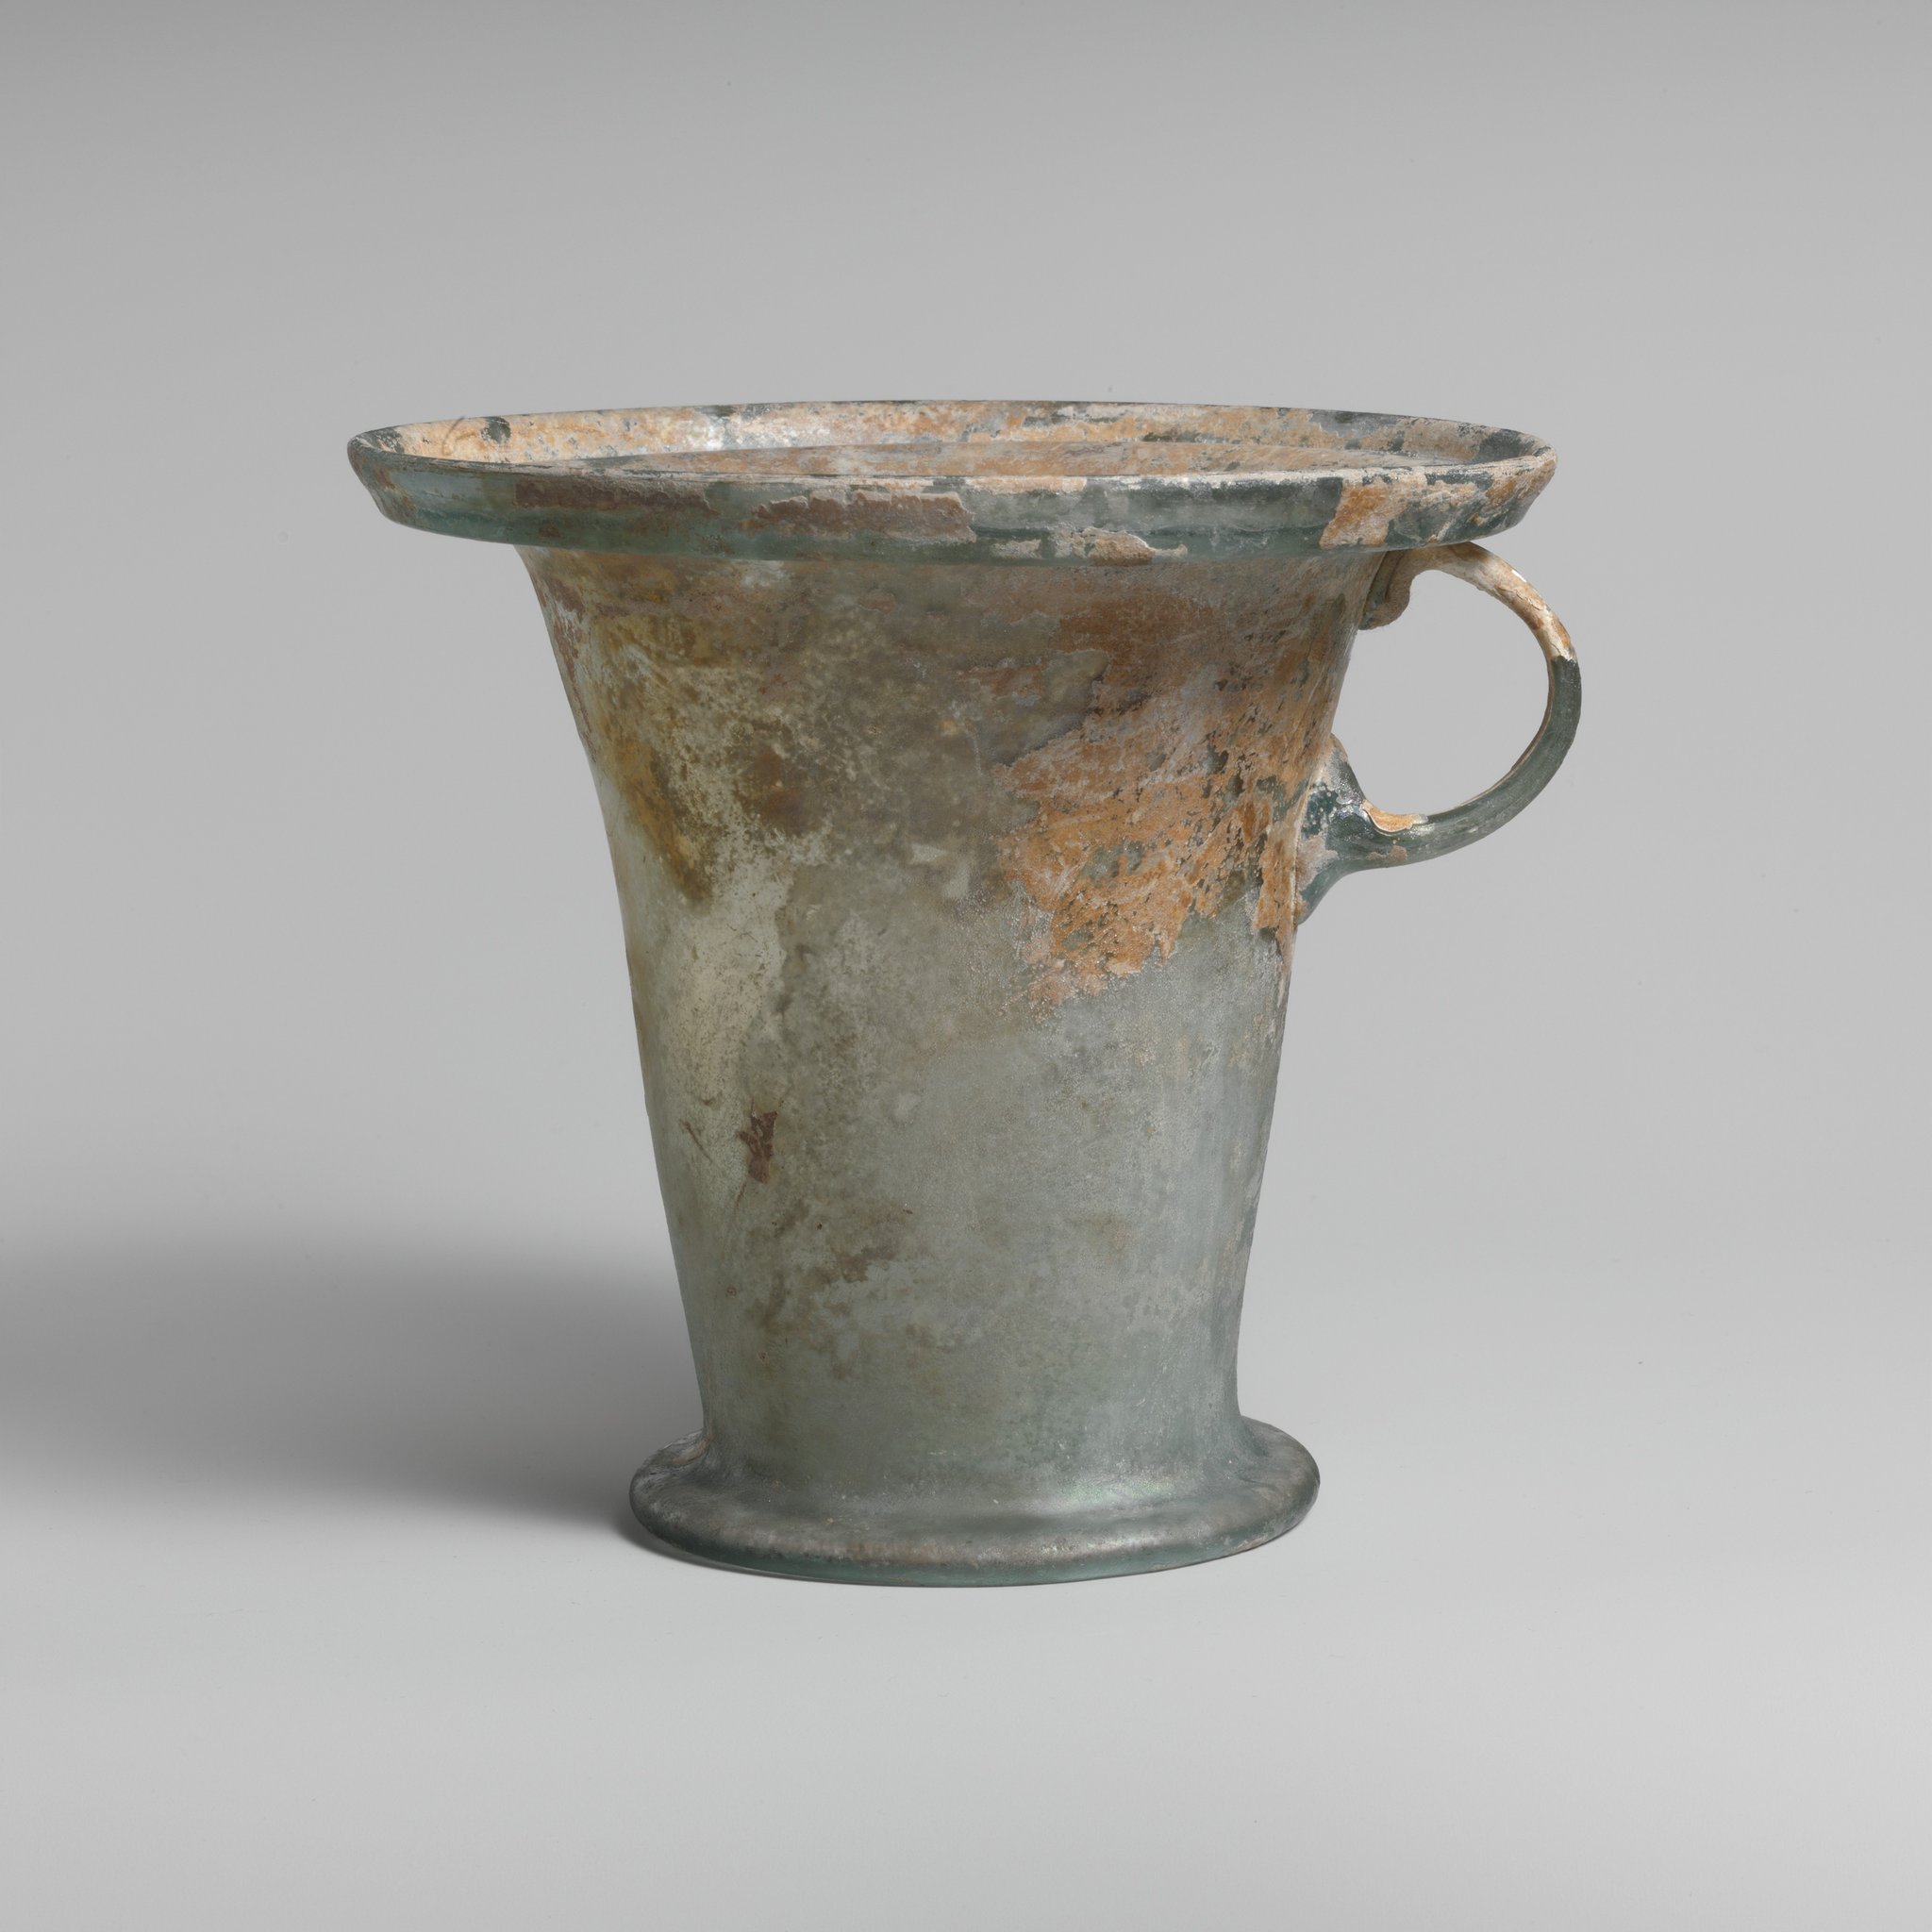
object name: cup, modiolus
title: Glass modiolus (one-handled cup)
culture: roman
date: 1-200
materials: glass